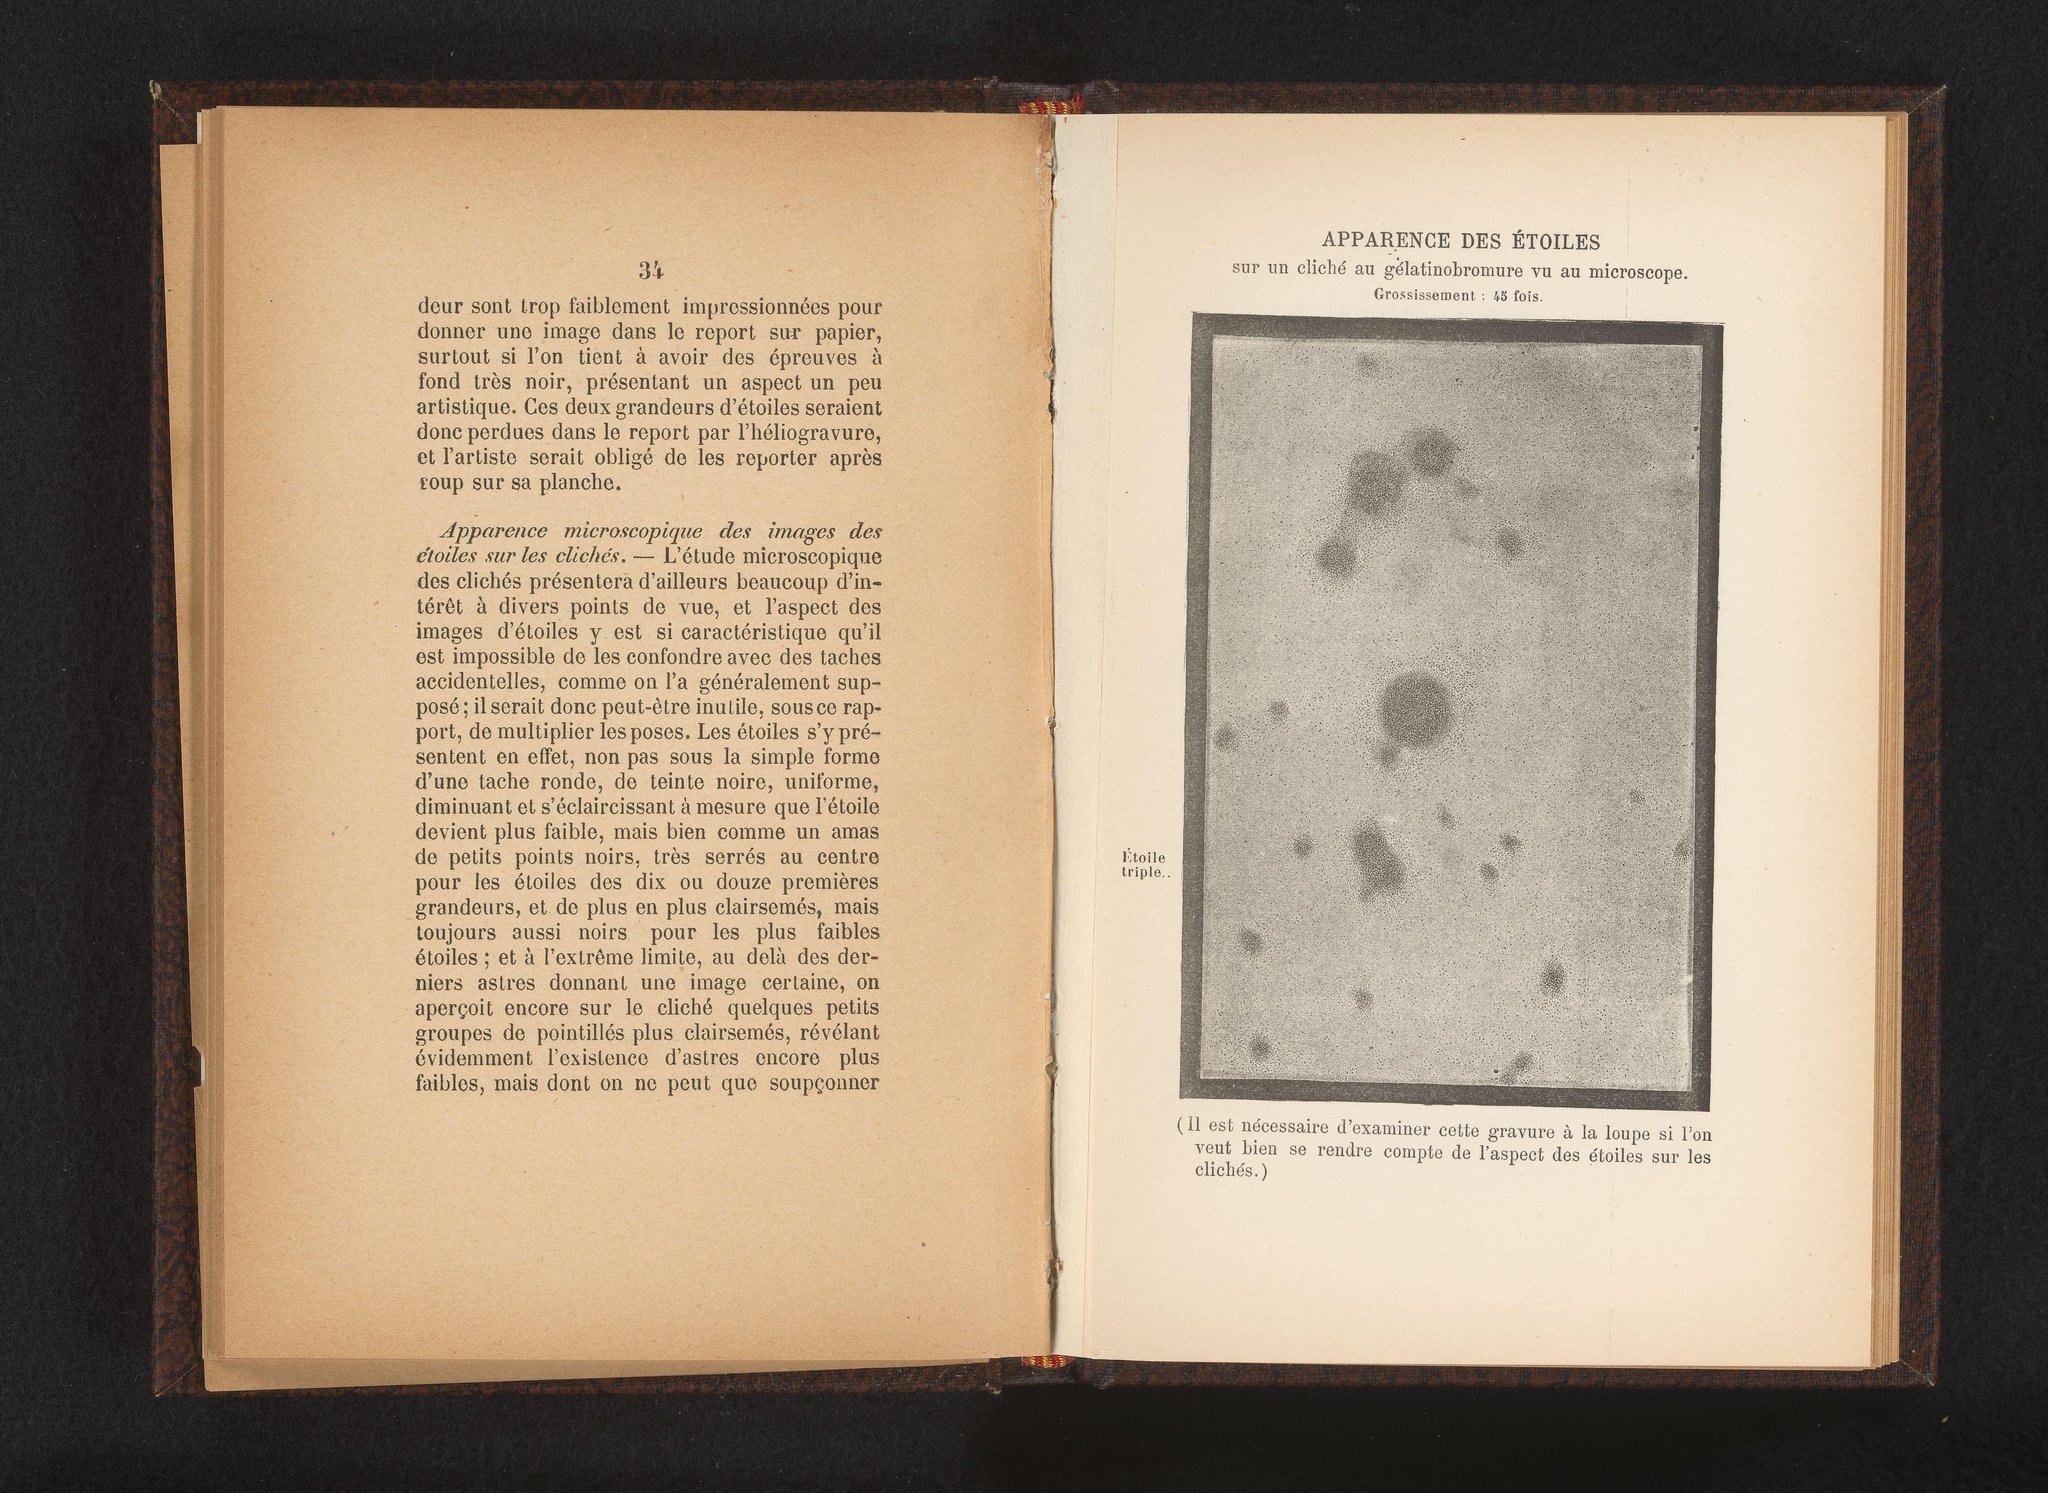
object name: page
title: Apparence des étoiles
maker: Anonymous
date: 1882-1887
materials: paper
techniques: photoaquatint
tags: stars and constellations